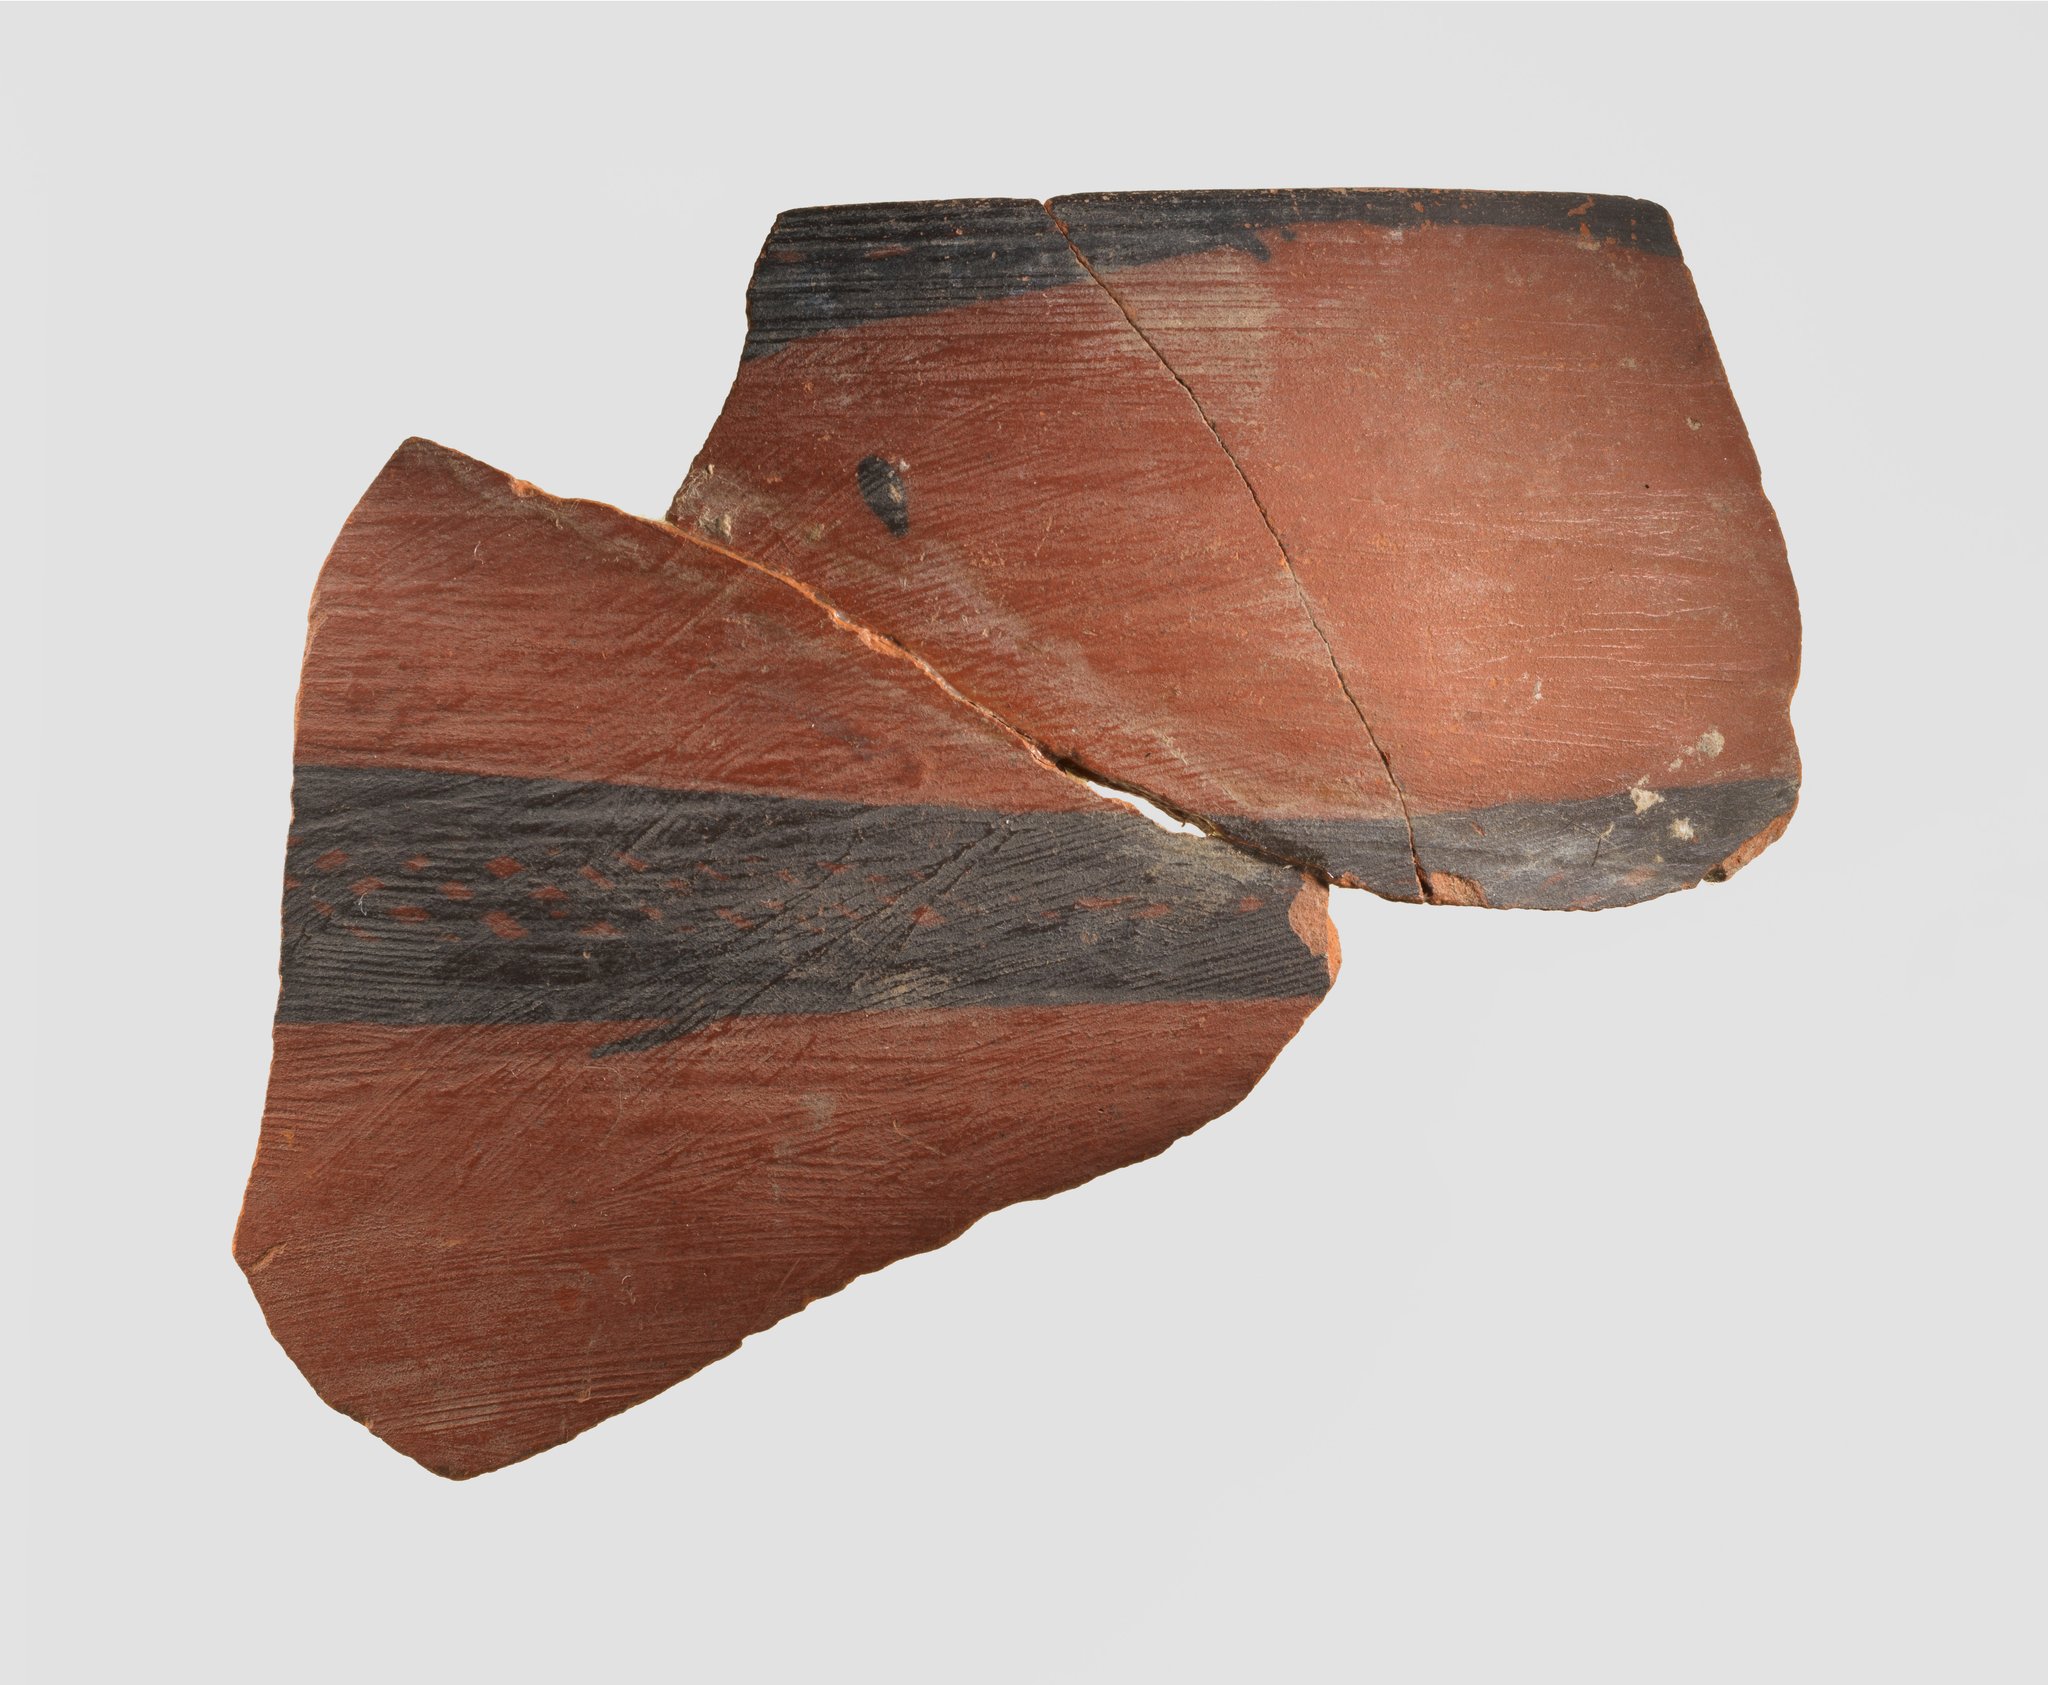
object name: sherd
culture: iranian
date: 4000-3500 BCE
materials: ceramic, glaze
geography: iran